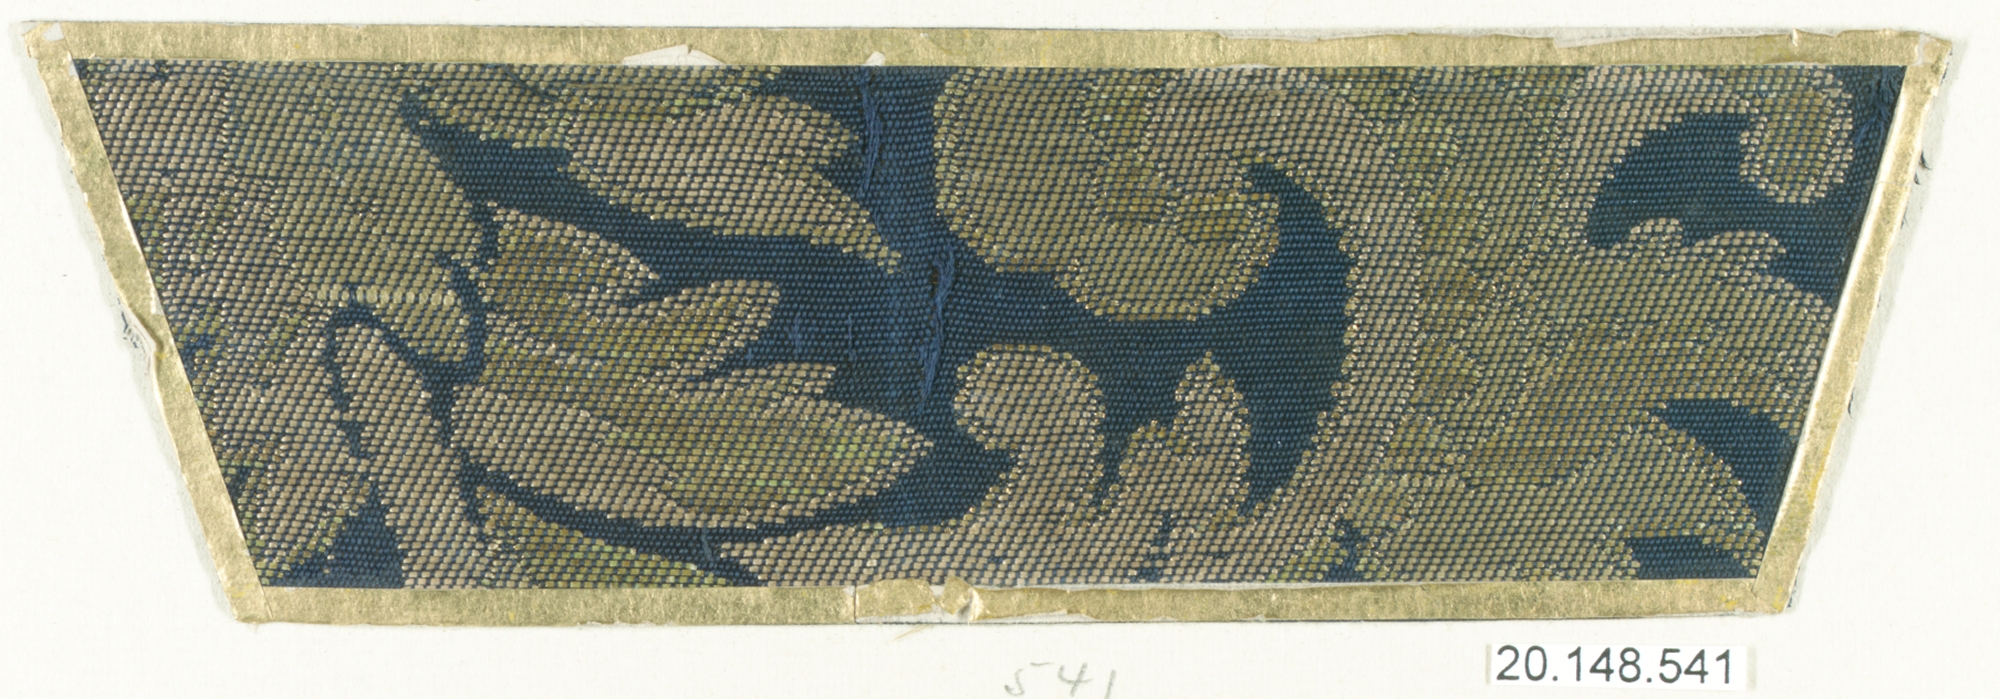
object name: piece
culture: japanese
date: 1701-1800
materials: silk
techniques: compound weave